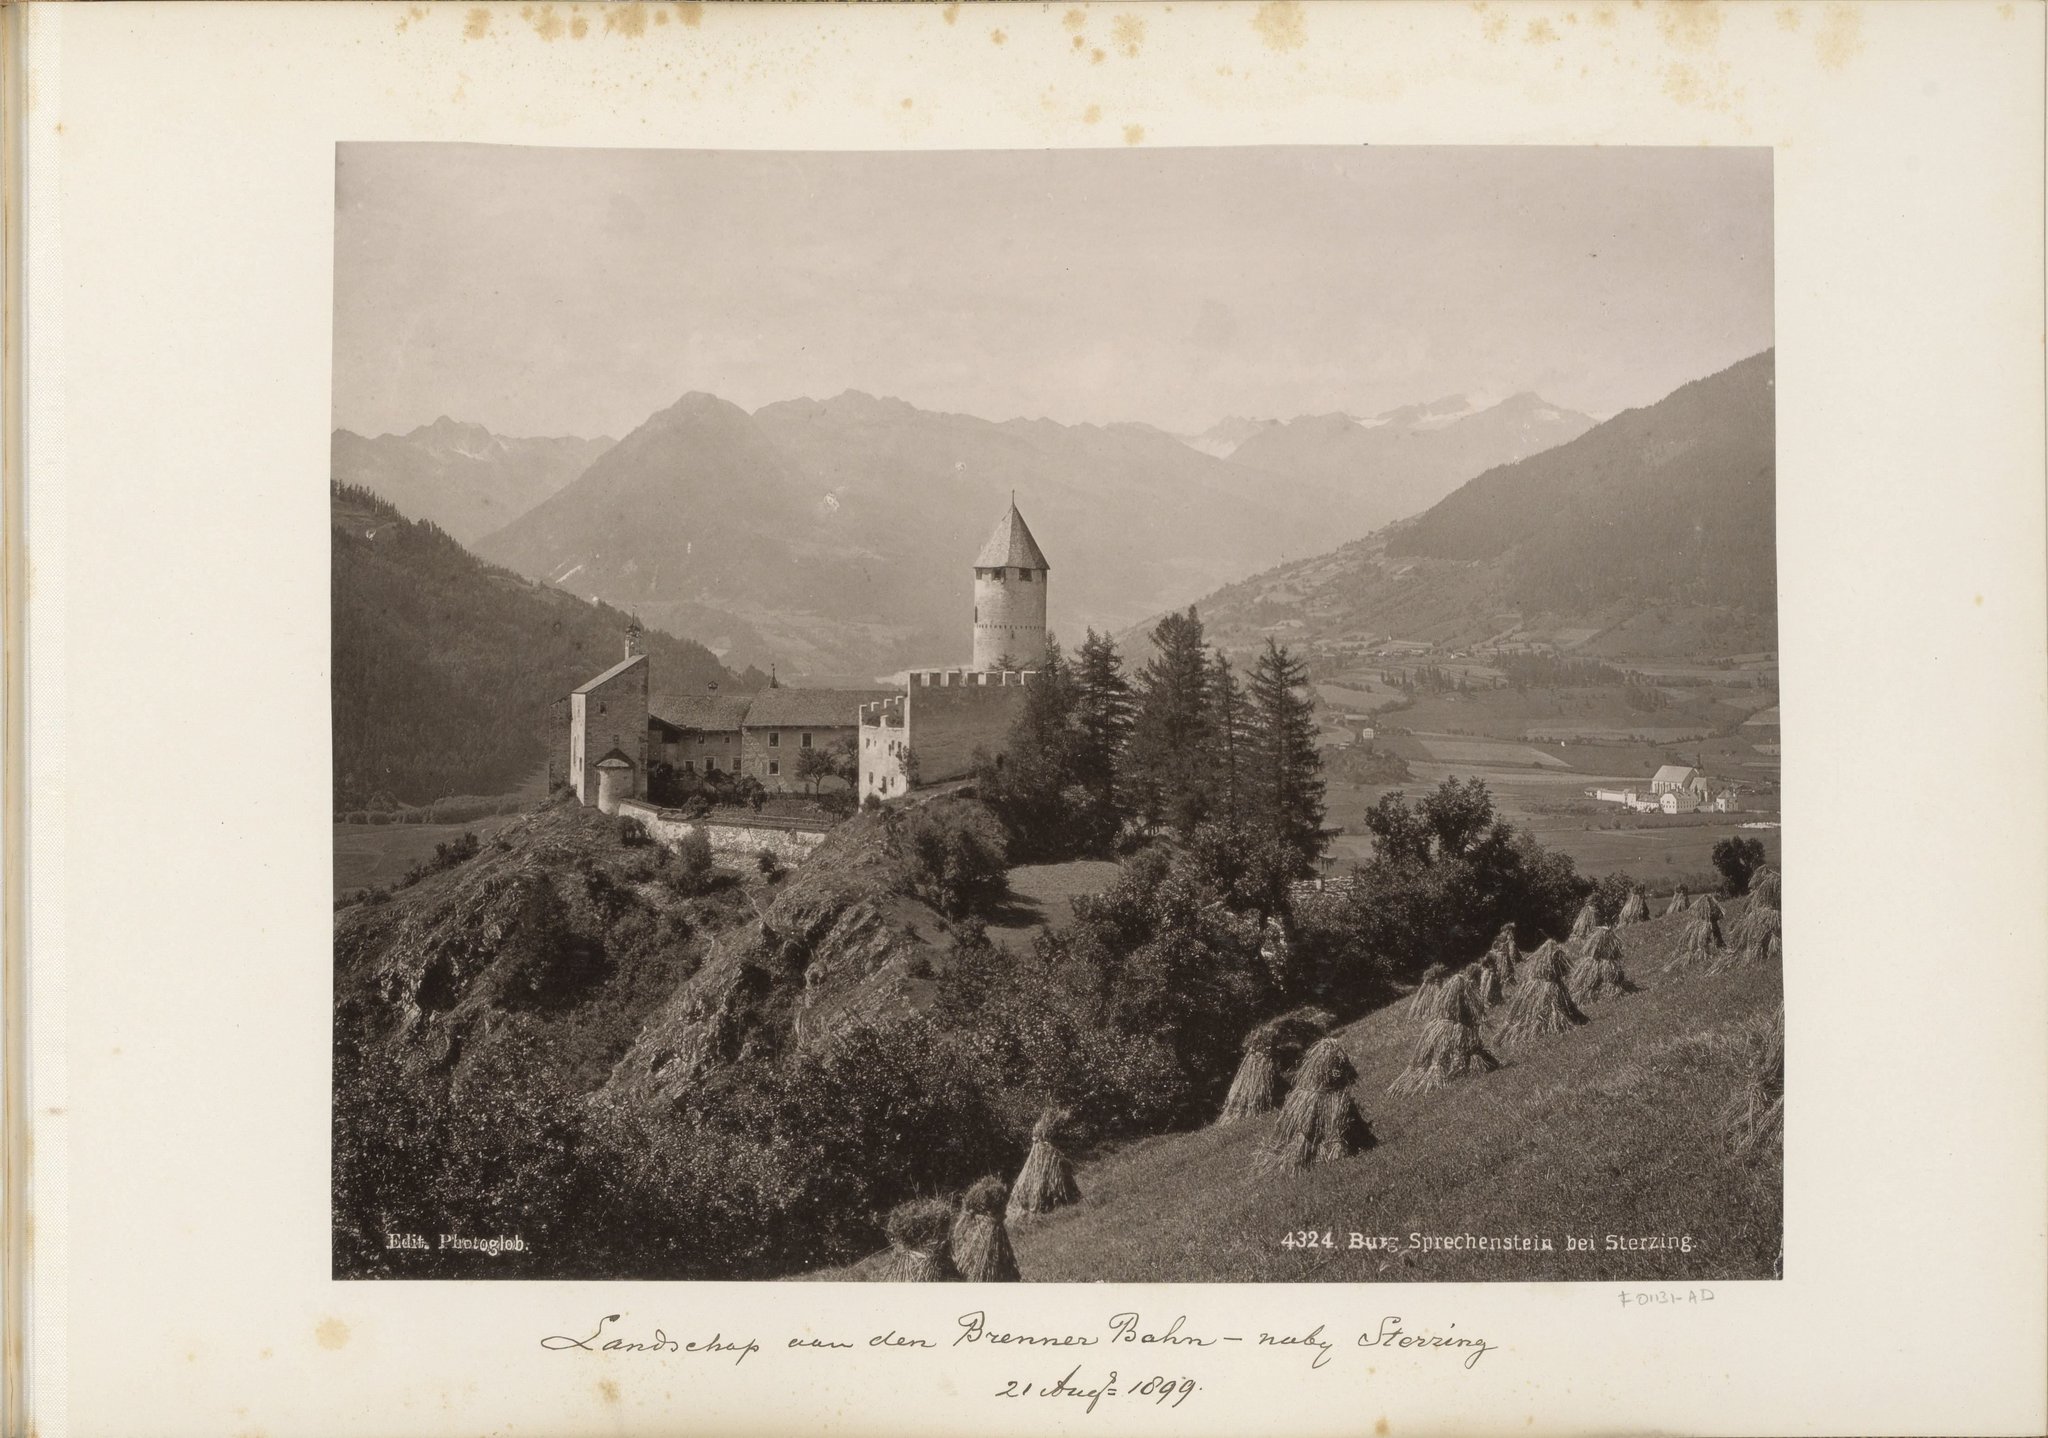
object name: album leaf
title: Gezicht op de burcht Sprechenstein bij Sterzing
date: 1880-1899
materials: paper, ink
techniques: photograph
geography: sterzing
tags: dale, valley, castle, hay-stack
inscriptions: number: ‘4324’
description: Onderdeel van Reisalbum met bezienswaardigheden in Duitsland, Oostenrijk, Zwitserland, Luxemburg en België.